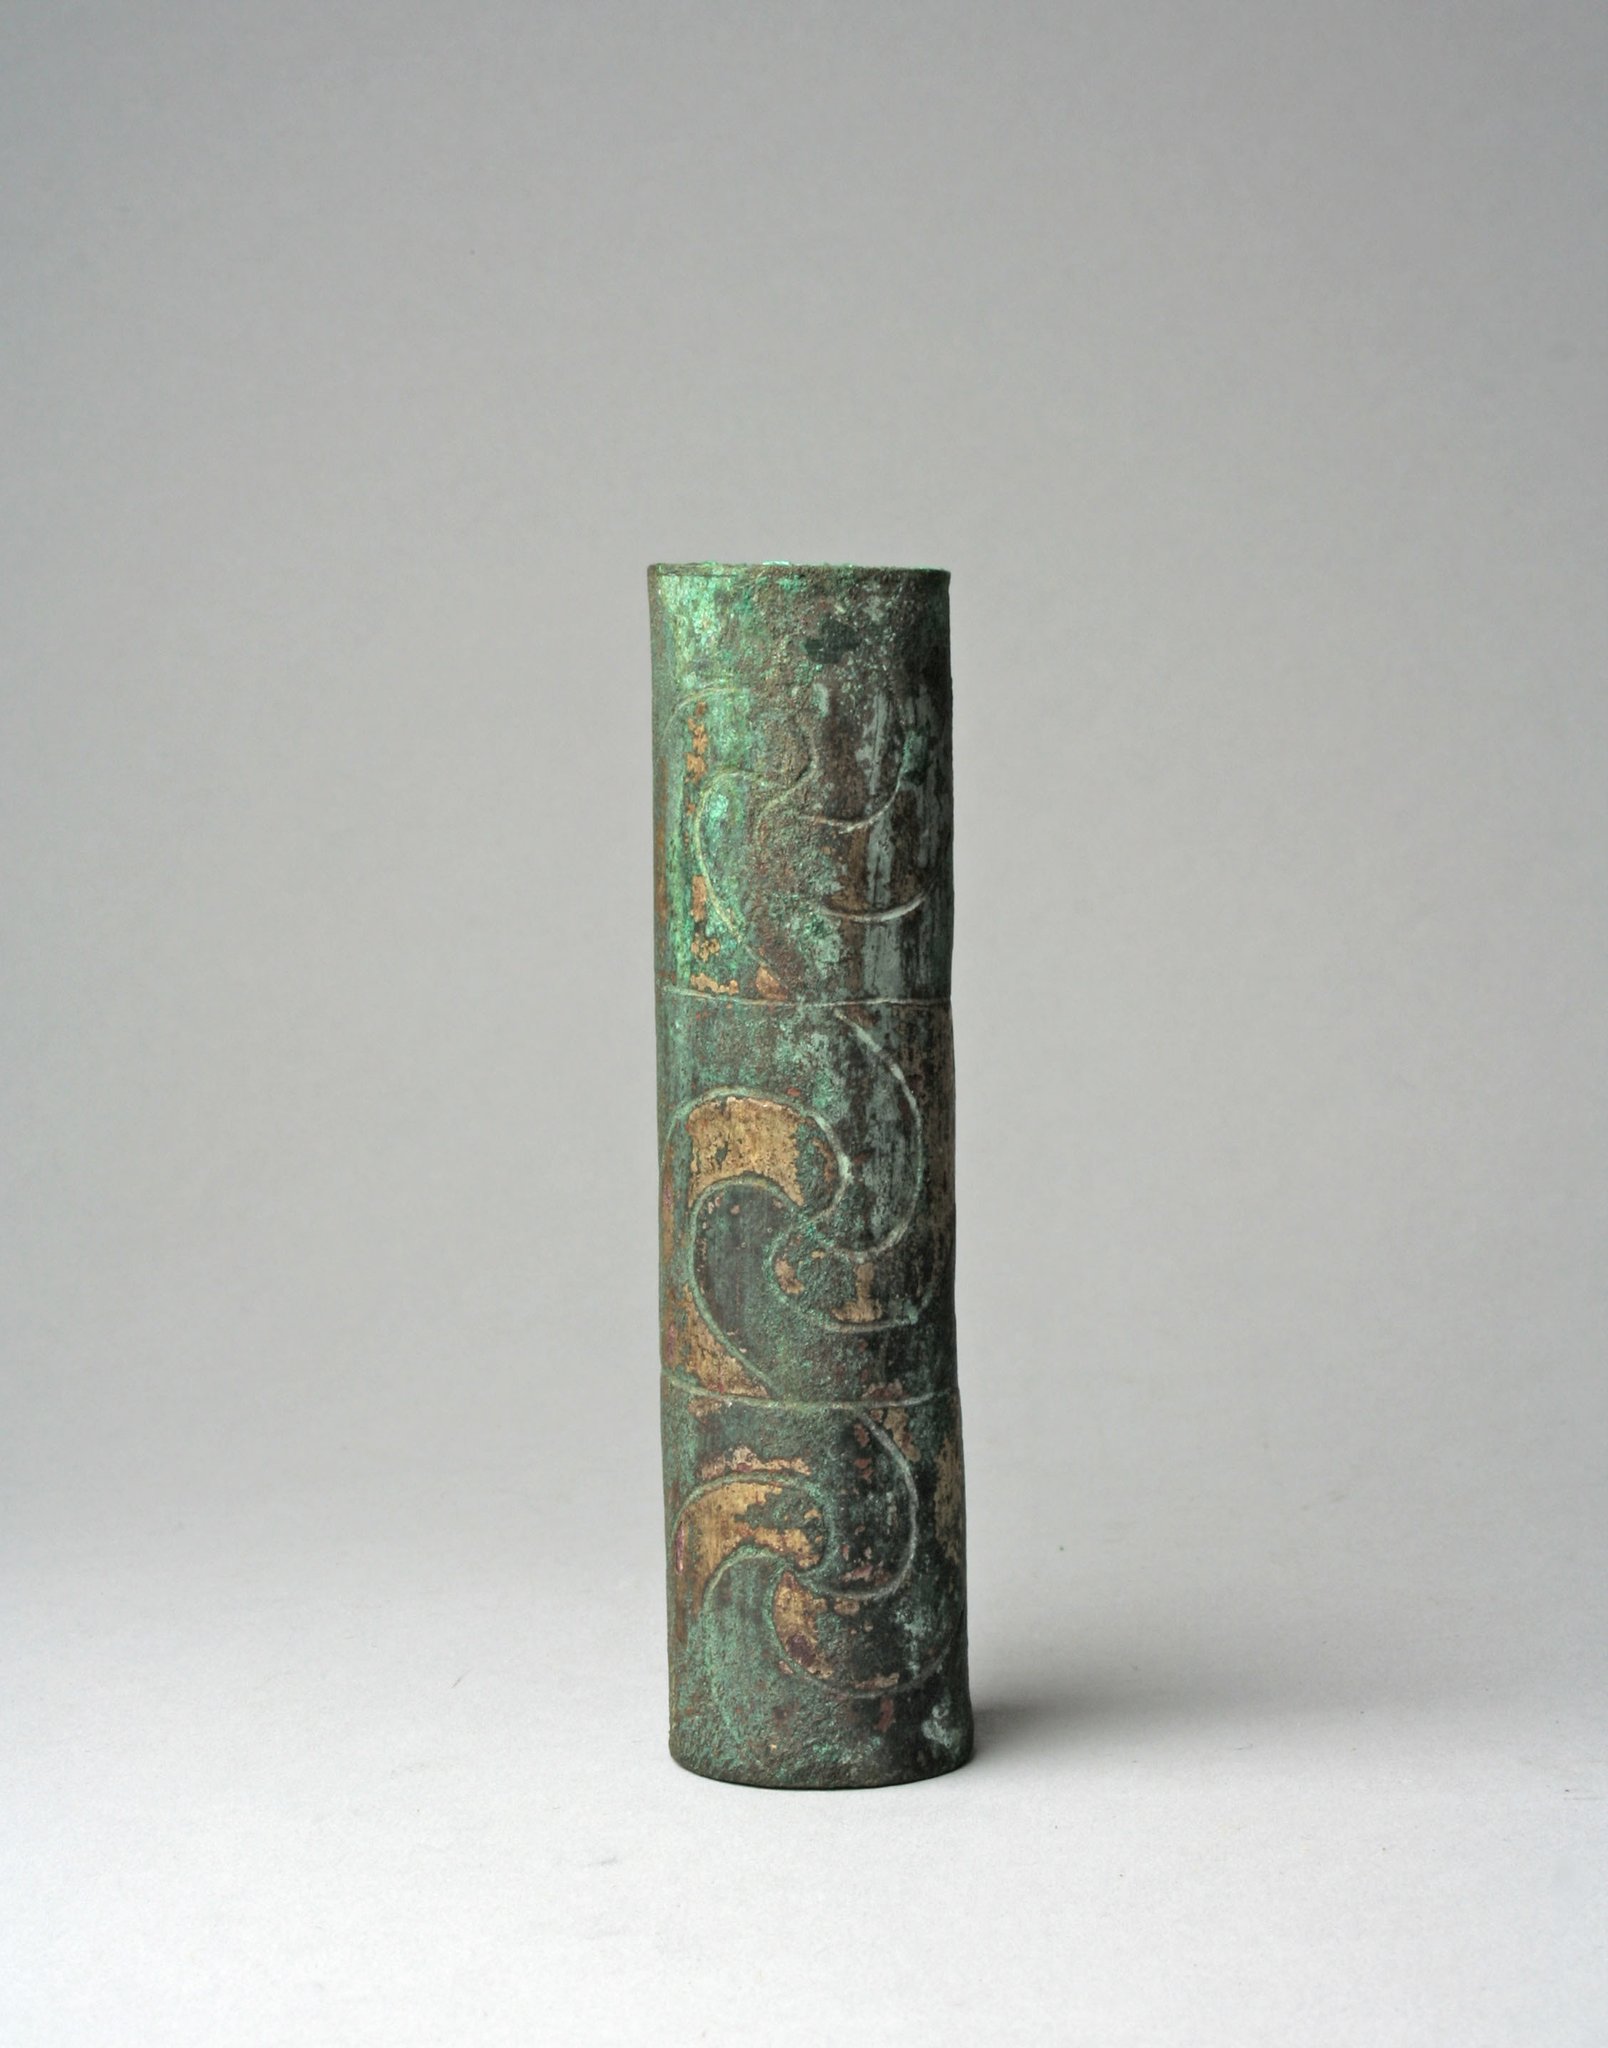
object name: bead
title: Tubular Bead with Spirals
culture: moche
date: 501-700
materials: copper, gilt copper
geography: peru